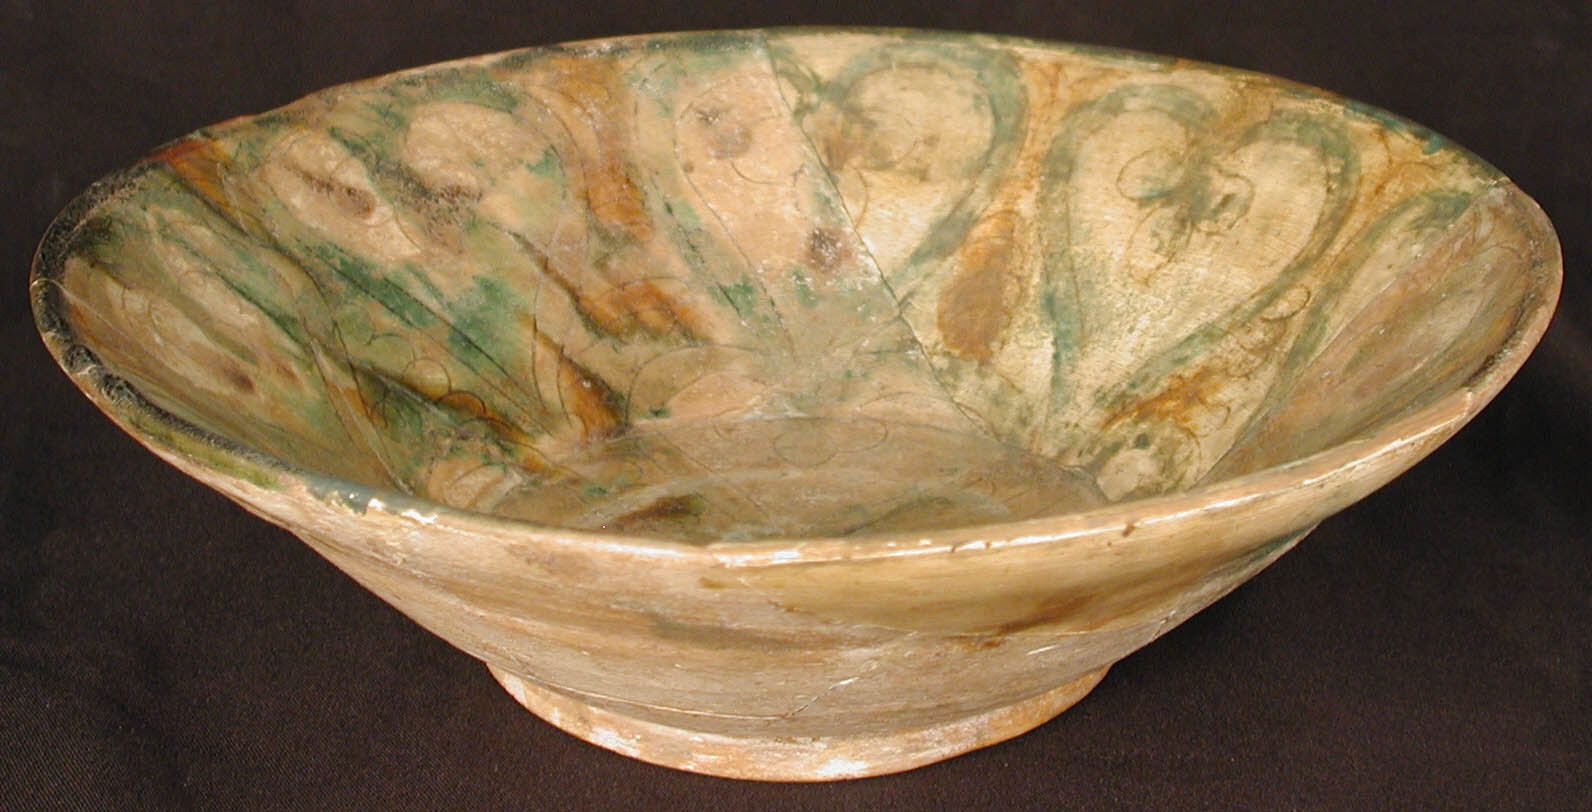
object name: bowl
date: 801-1000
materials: earthenware, glaze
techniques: incising, polychrome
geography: iran